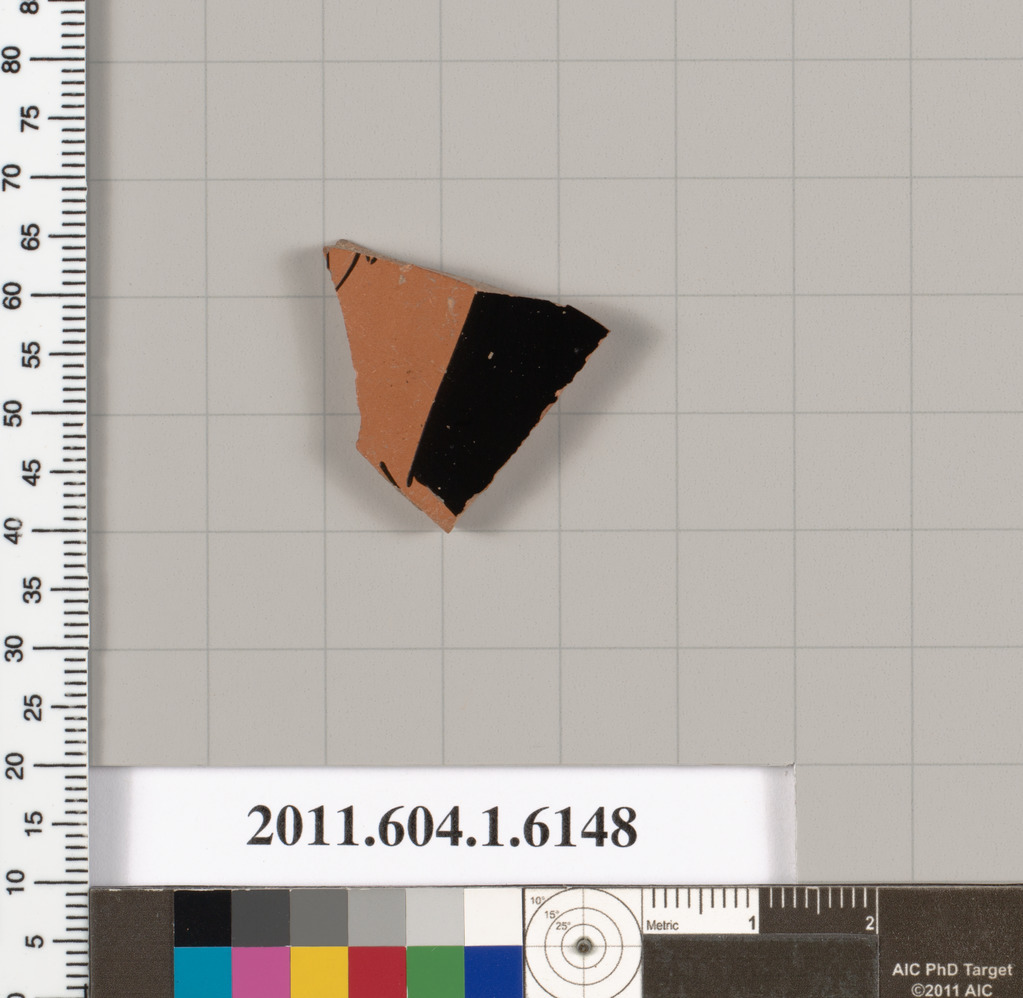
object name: kylix fragment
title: Terracotta fragment of a kylix (drinking cup)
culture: greek, attic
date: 520-500 BCE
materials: terracotta